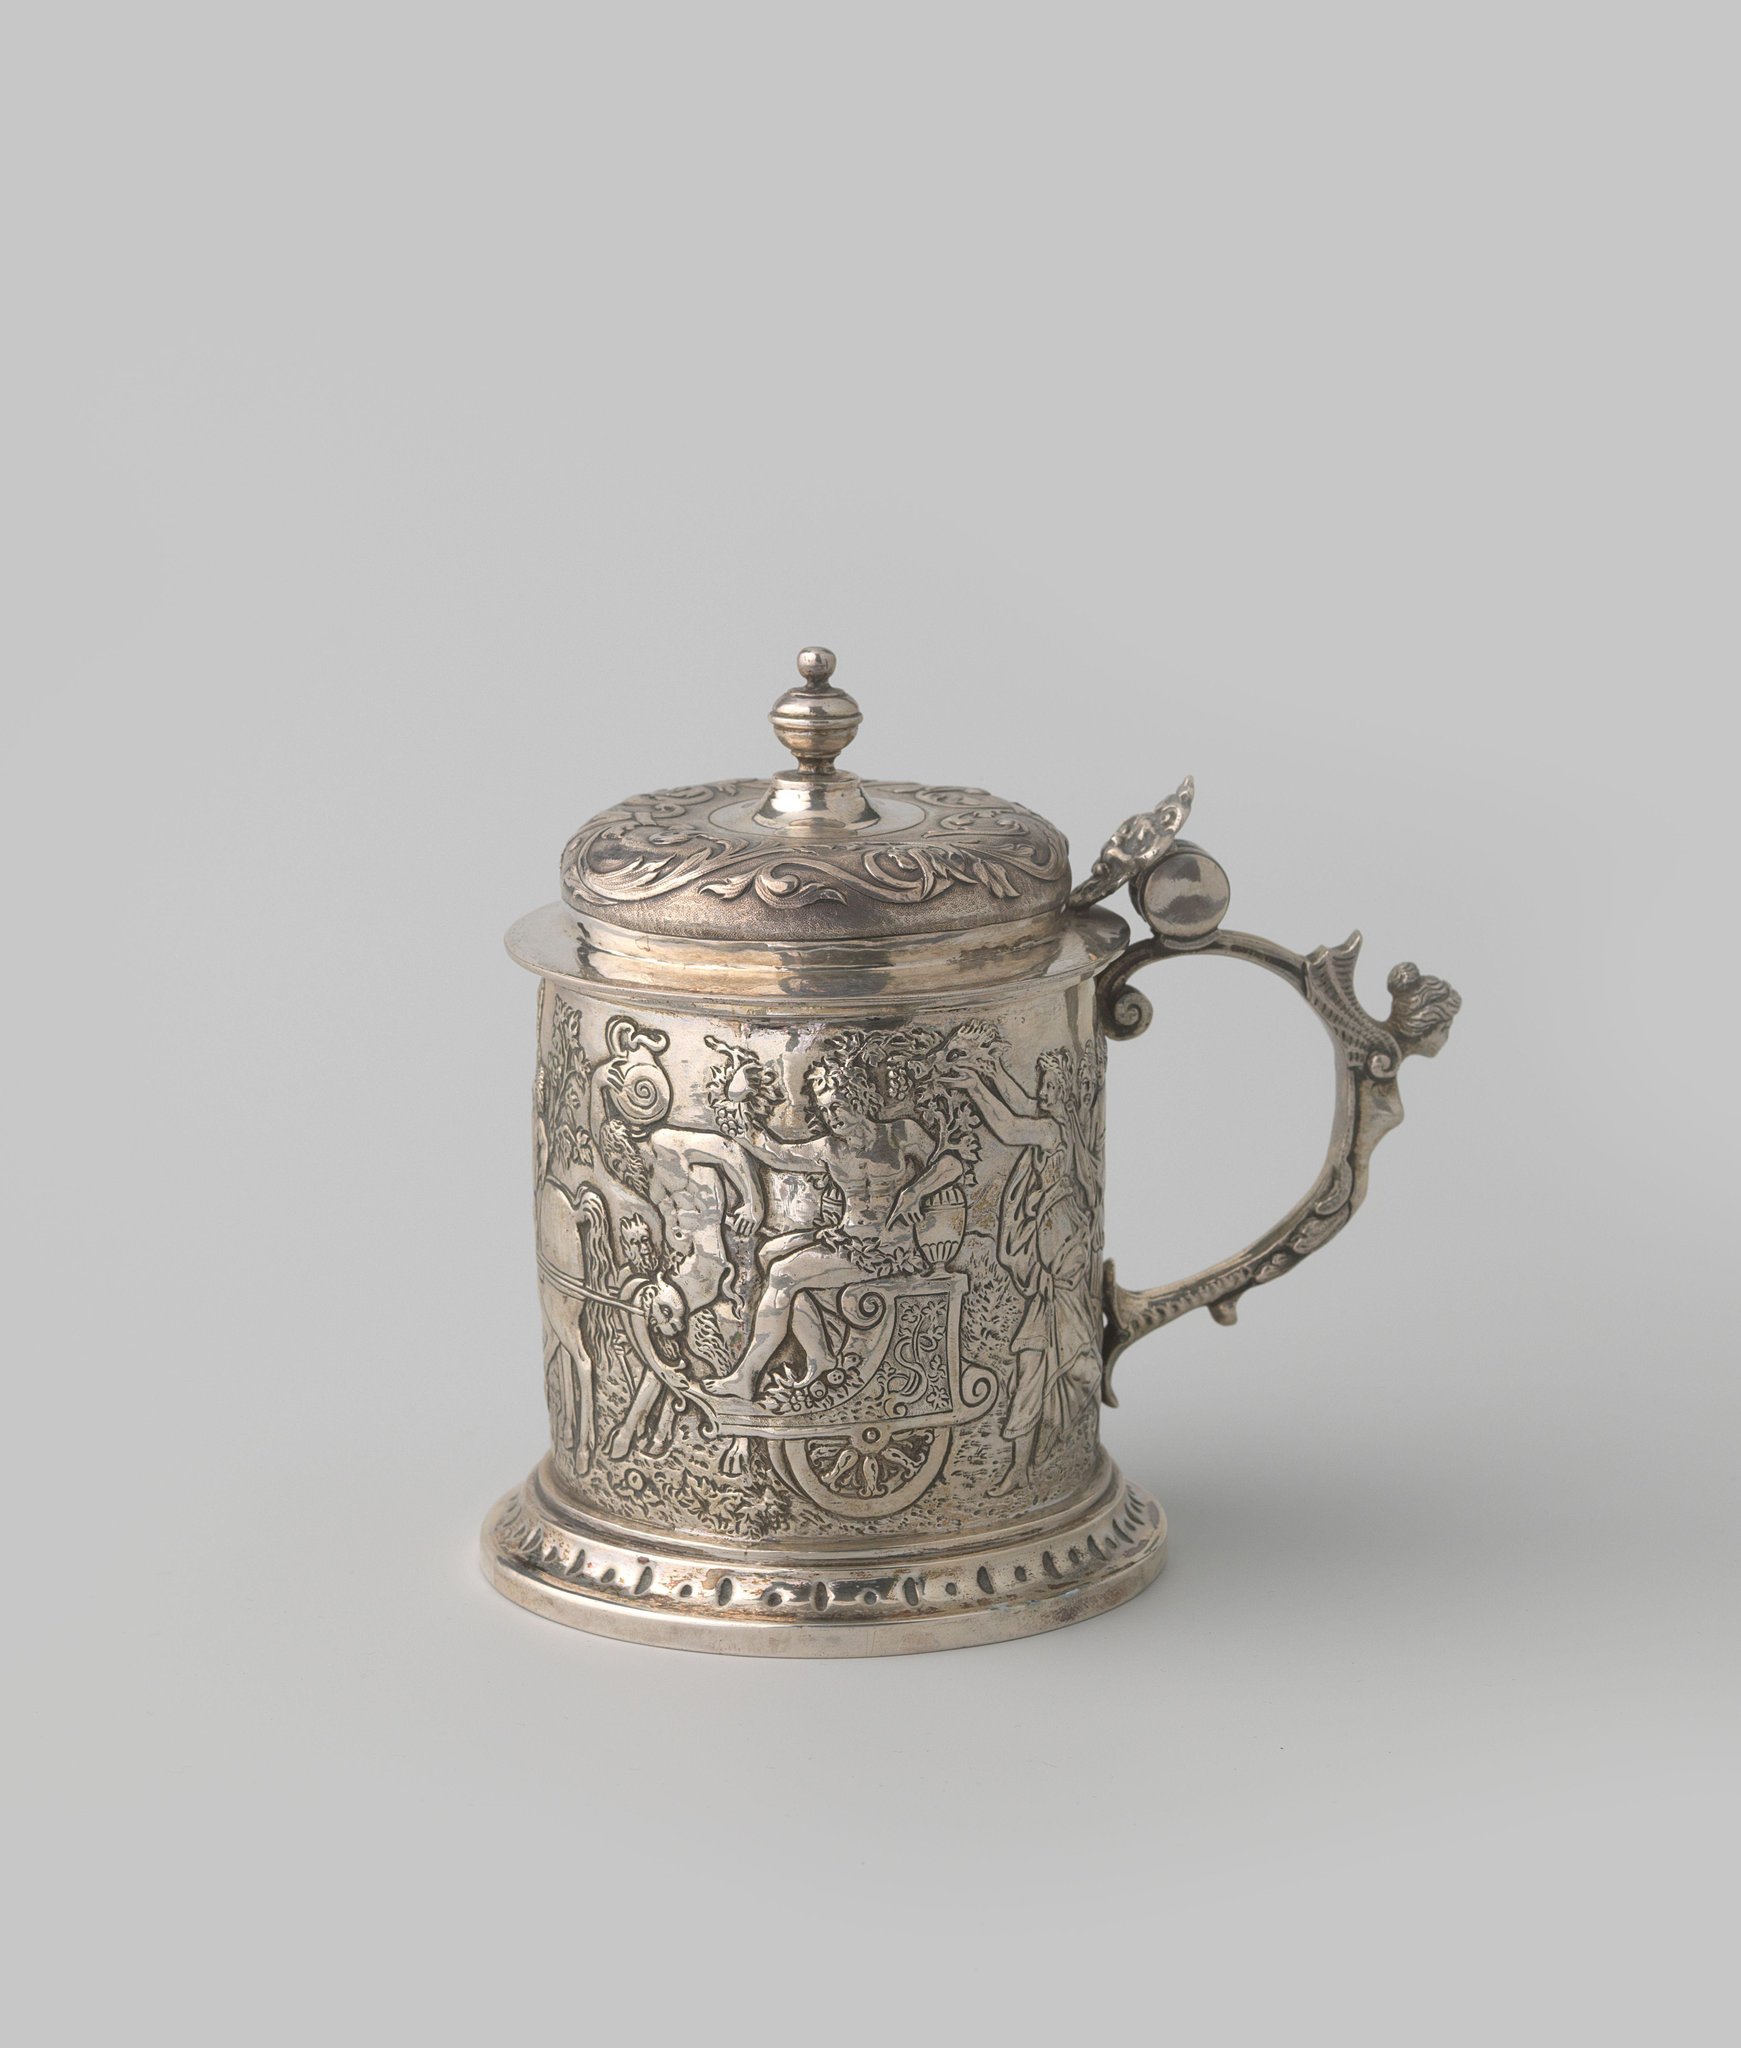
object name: cup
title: Beker van zilver met oor waarop een gevleugelde vrouwenfiguur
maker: Anonymous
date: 1650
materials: silver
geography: franeker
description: Beker van zilver, met oor en klapdeksel. Versierd met een gedreven triomftocht. Aan het oor een gevleugelde vrouwenfiguur. Vals?